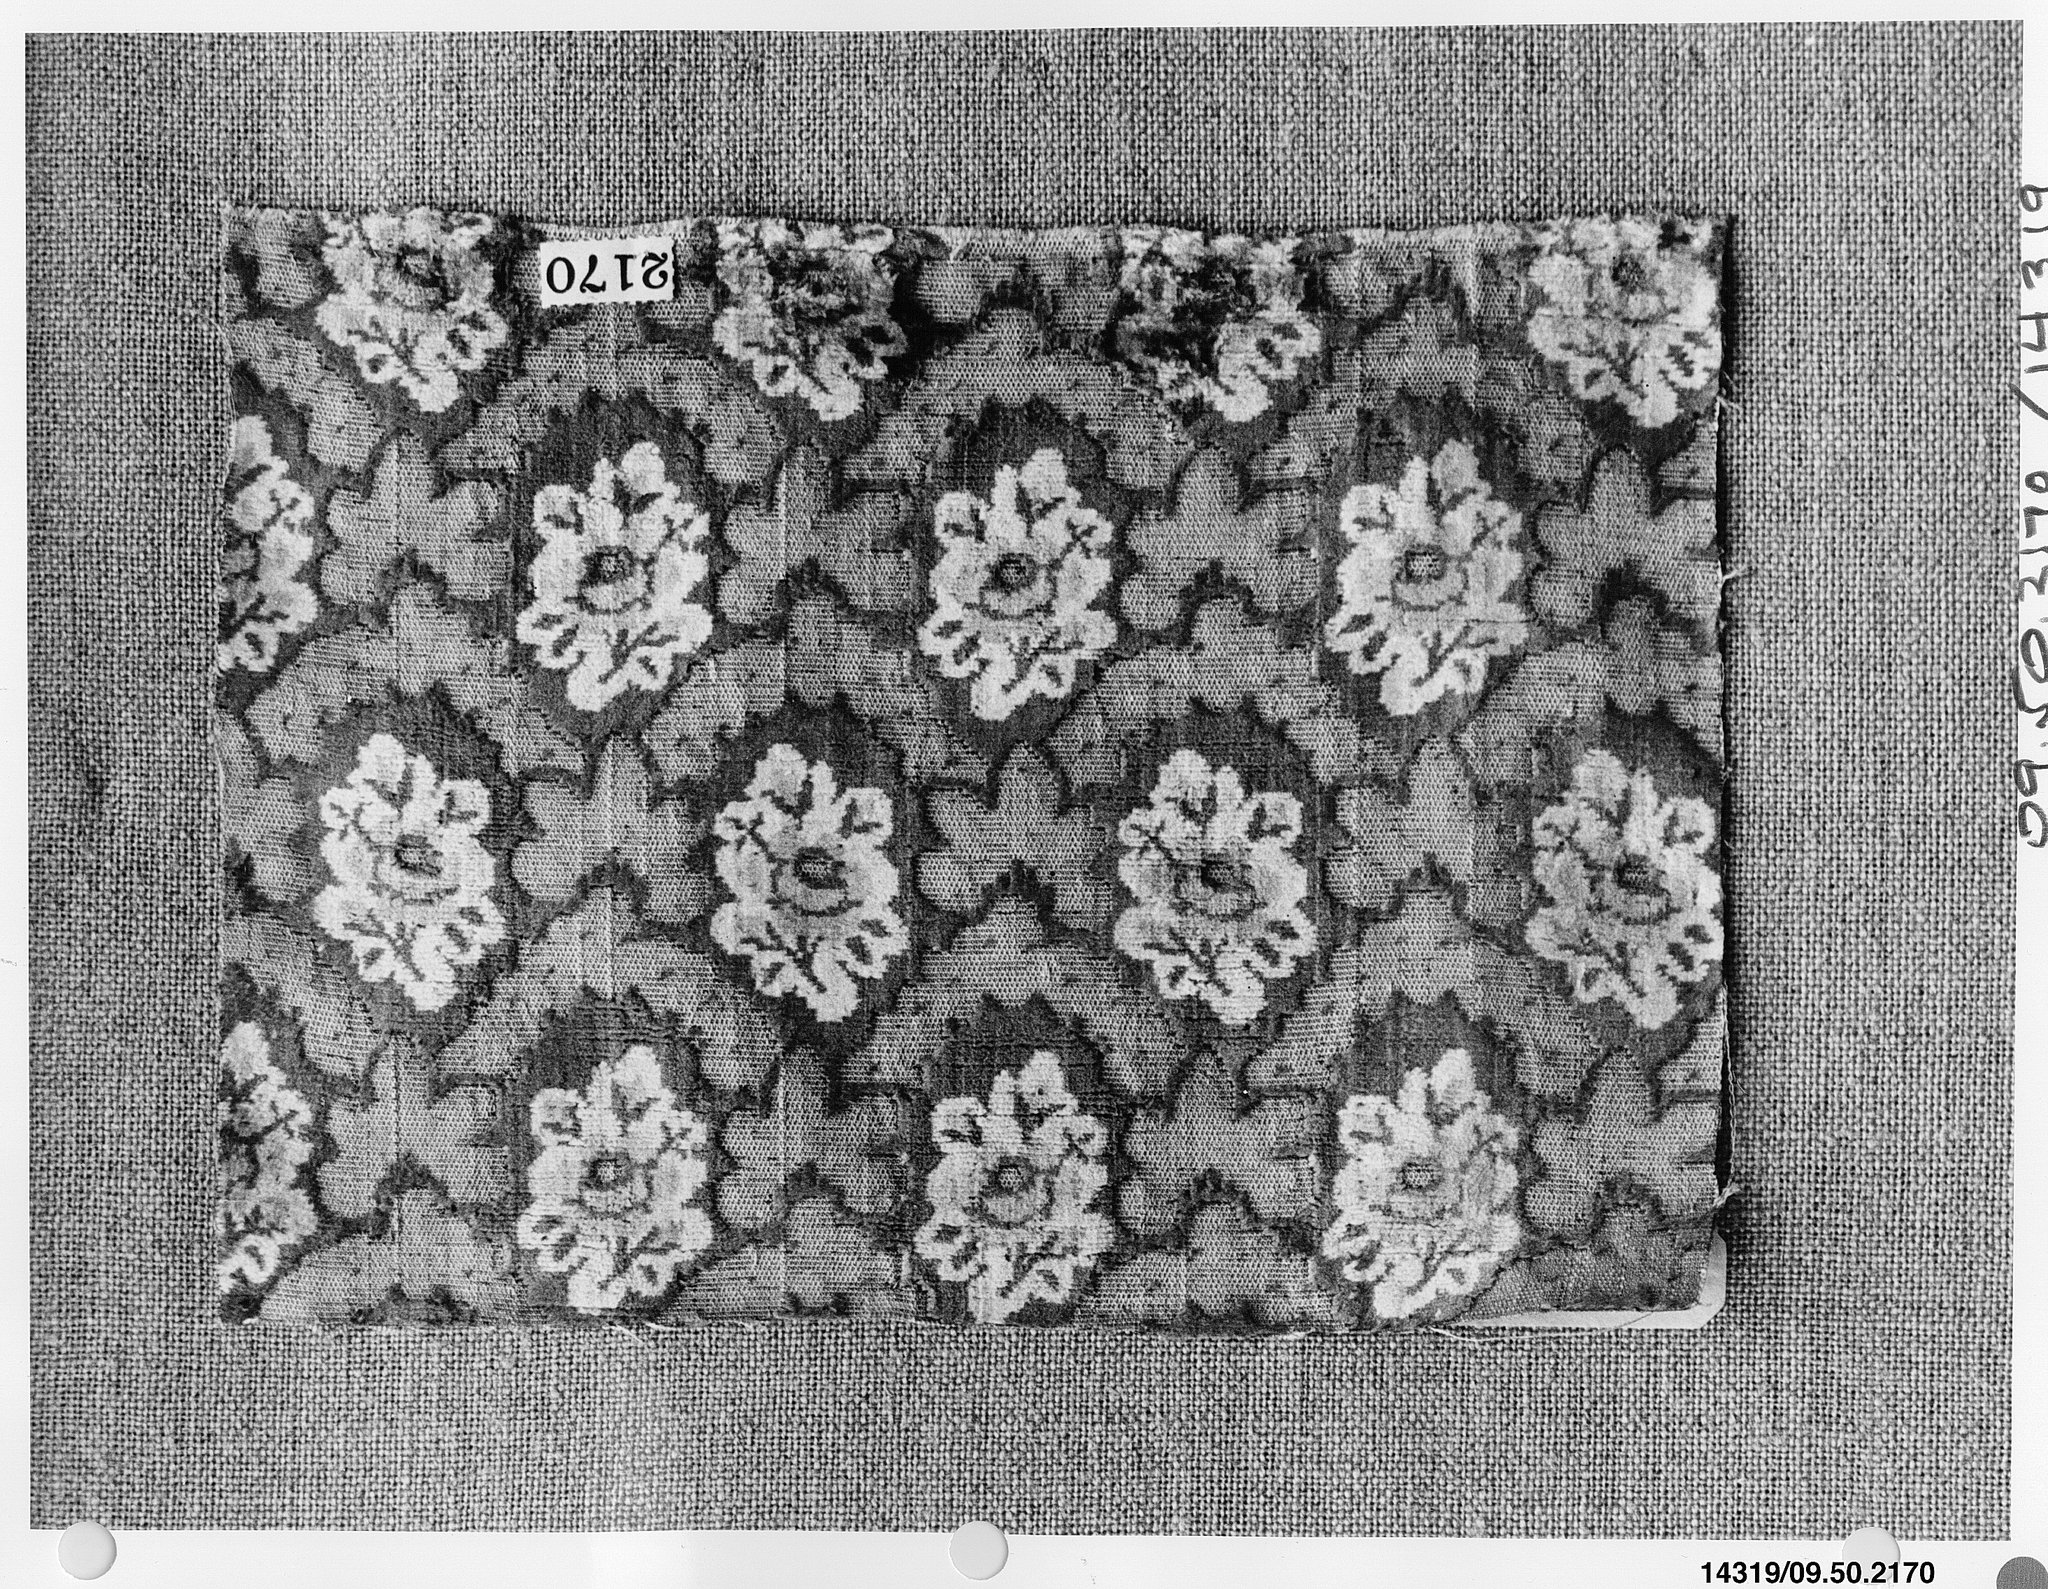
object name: piece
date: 1701-1800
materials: metal thread, silk